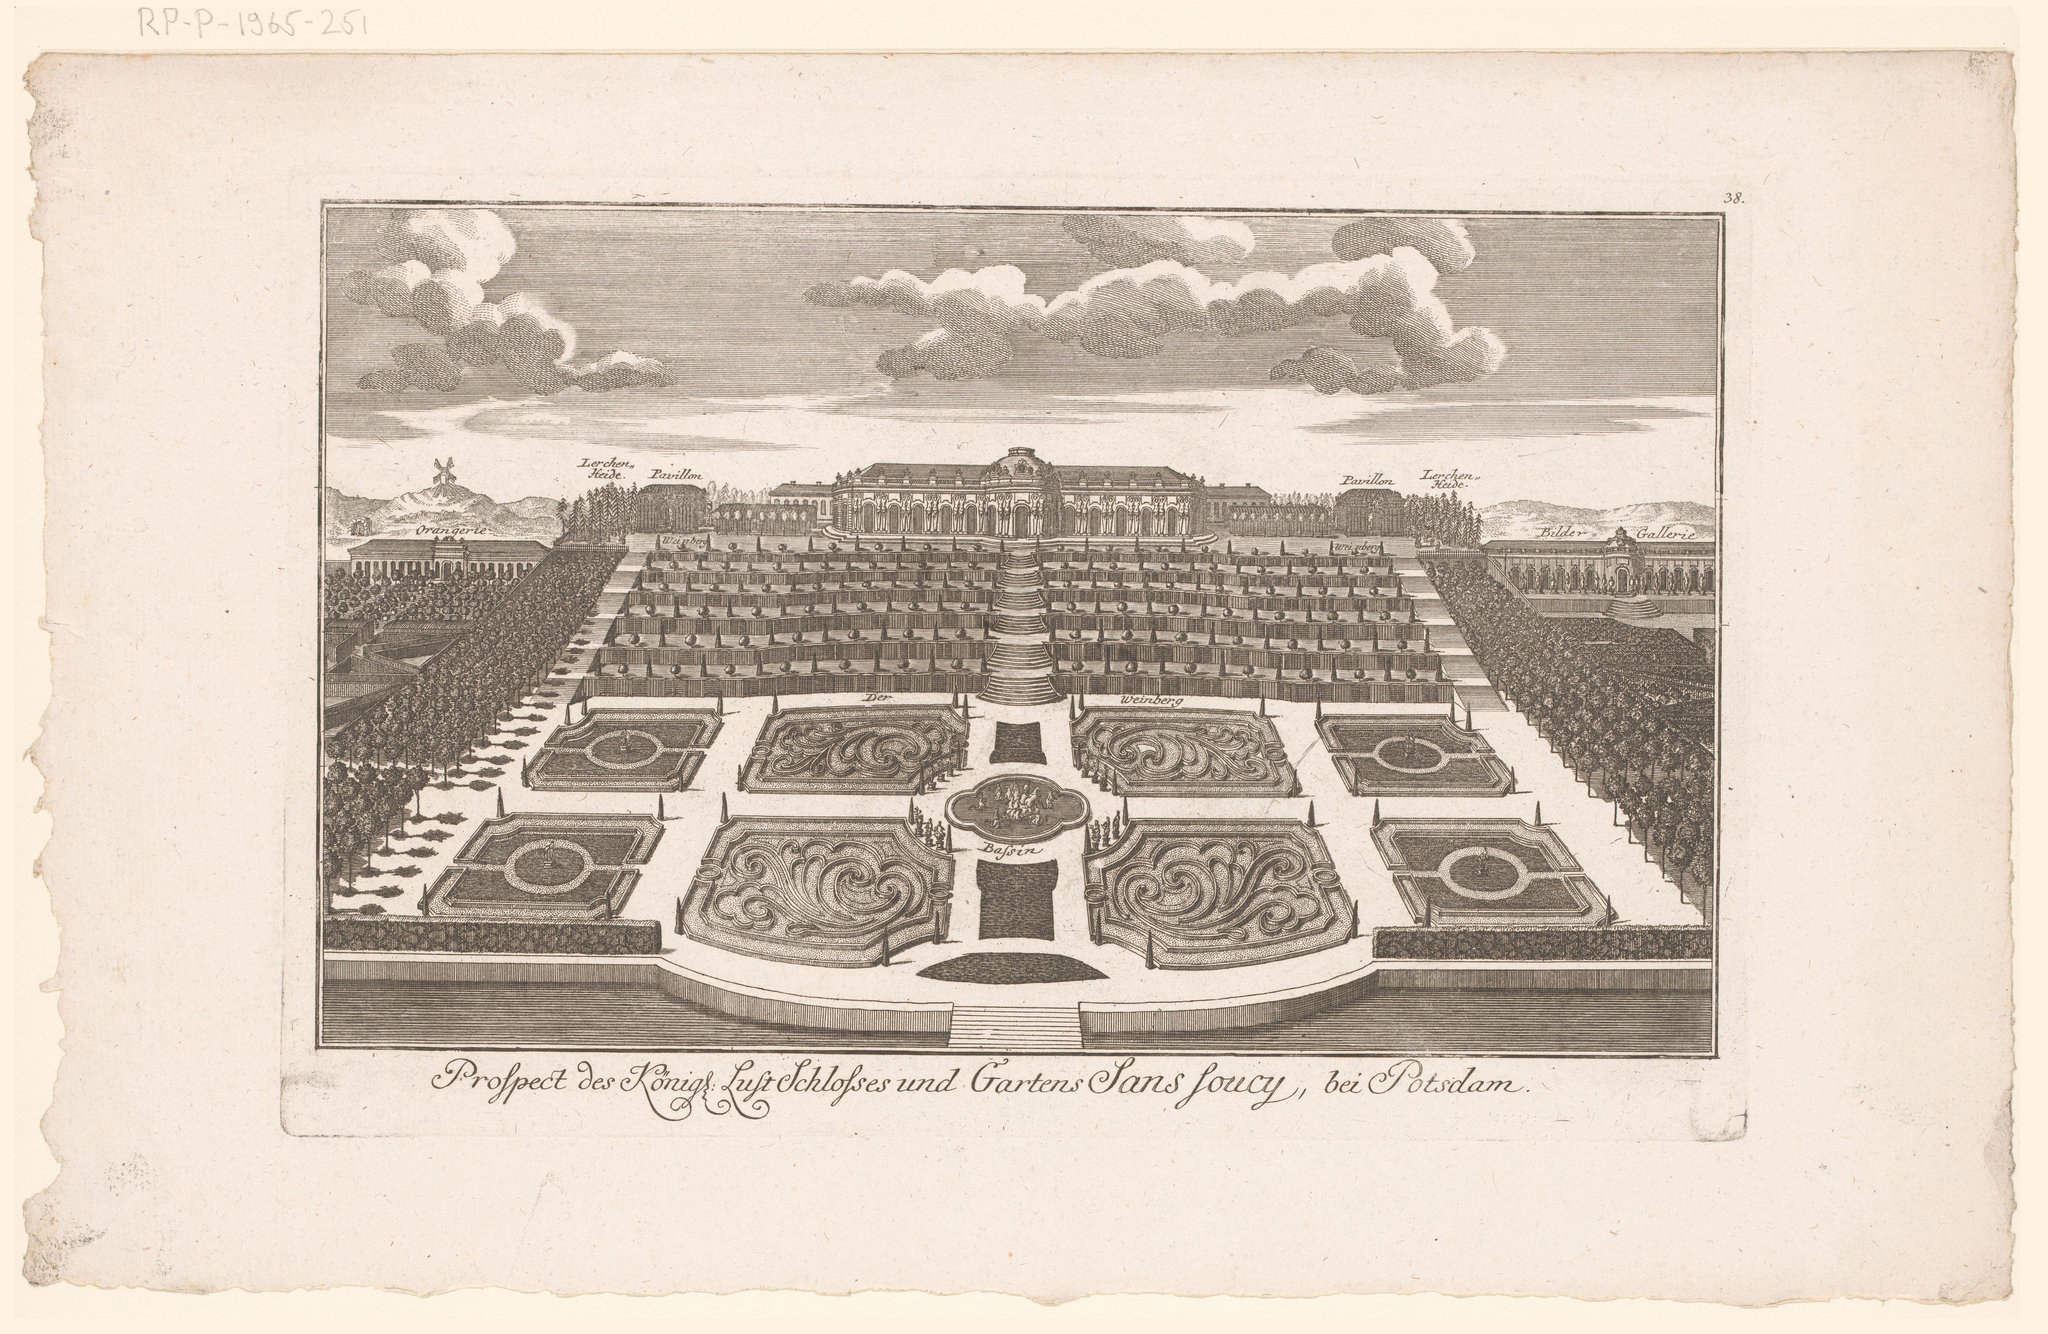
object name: print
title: Prospect des Königl. Lust Schlosses und Gartens Sanssoucy, bei Potsdam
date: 1747-1774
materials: paper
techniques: engraving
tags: castle, french or architectonic garden; formal garden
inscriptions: collector's mark: Lugt 2228, collector's mark: Lugt 2760